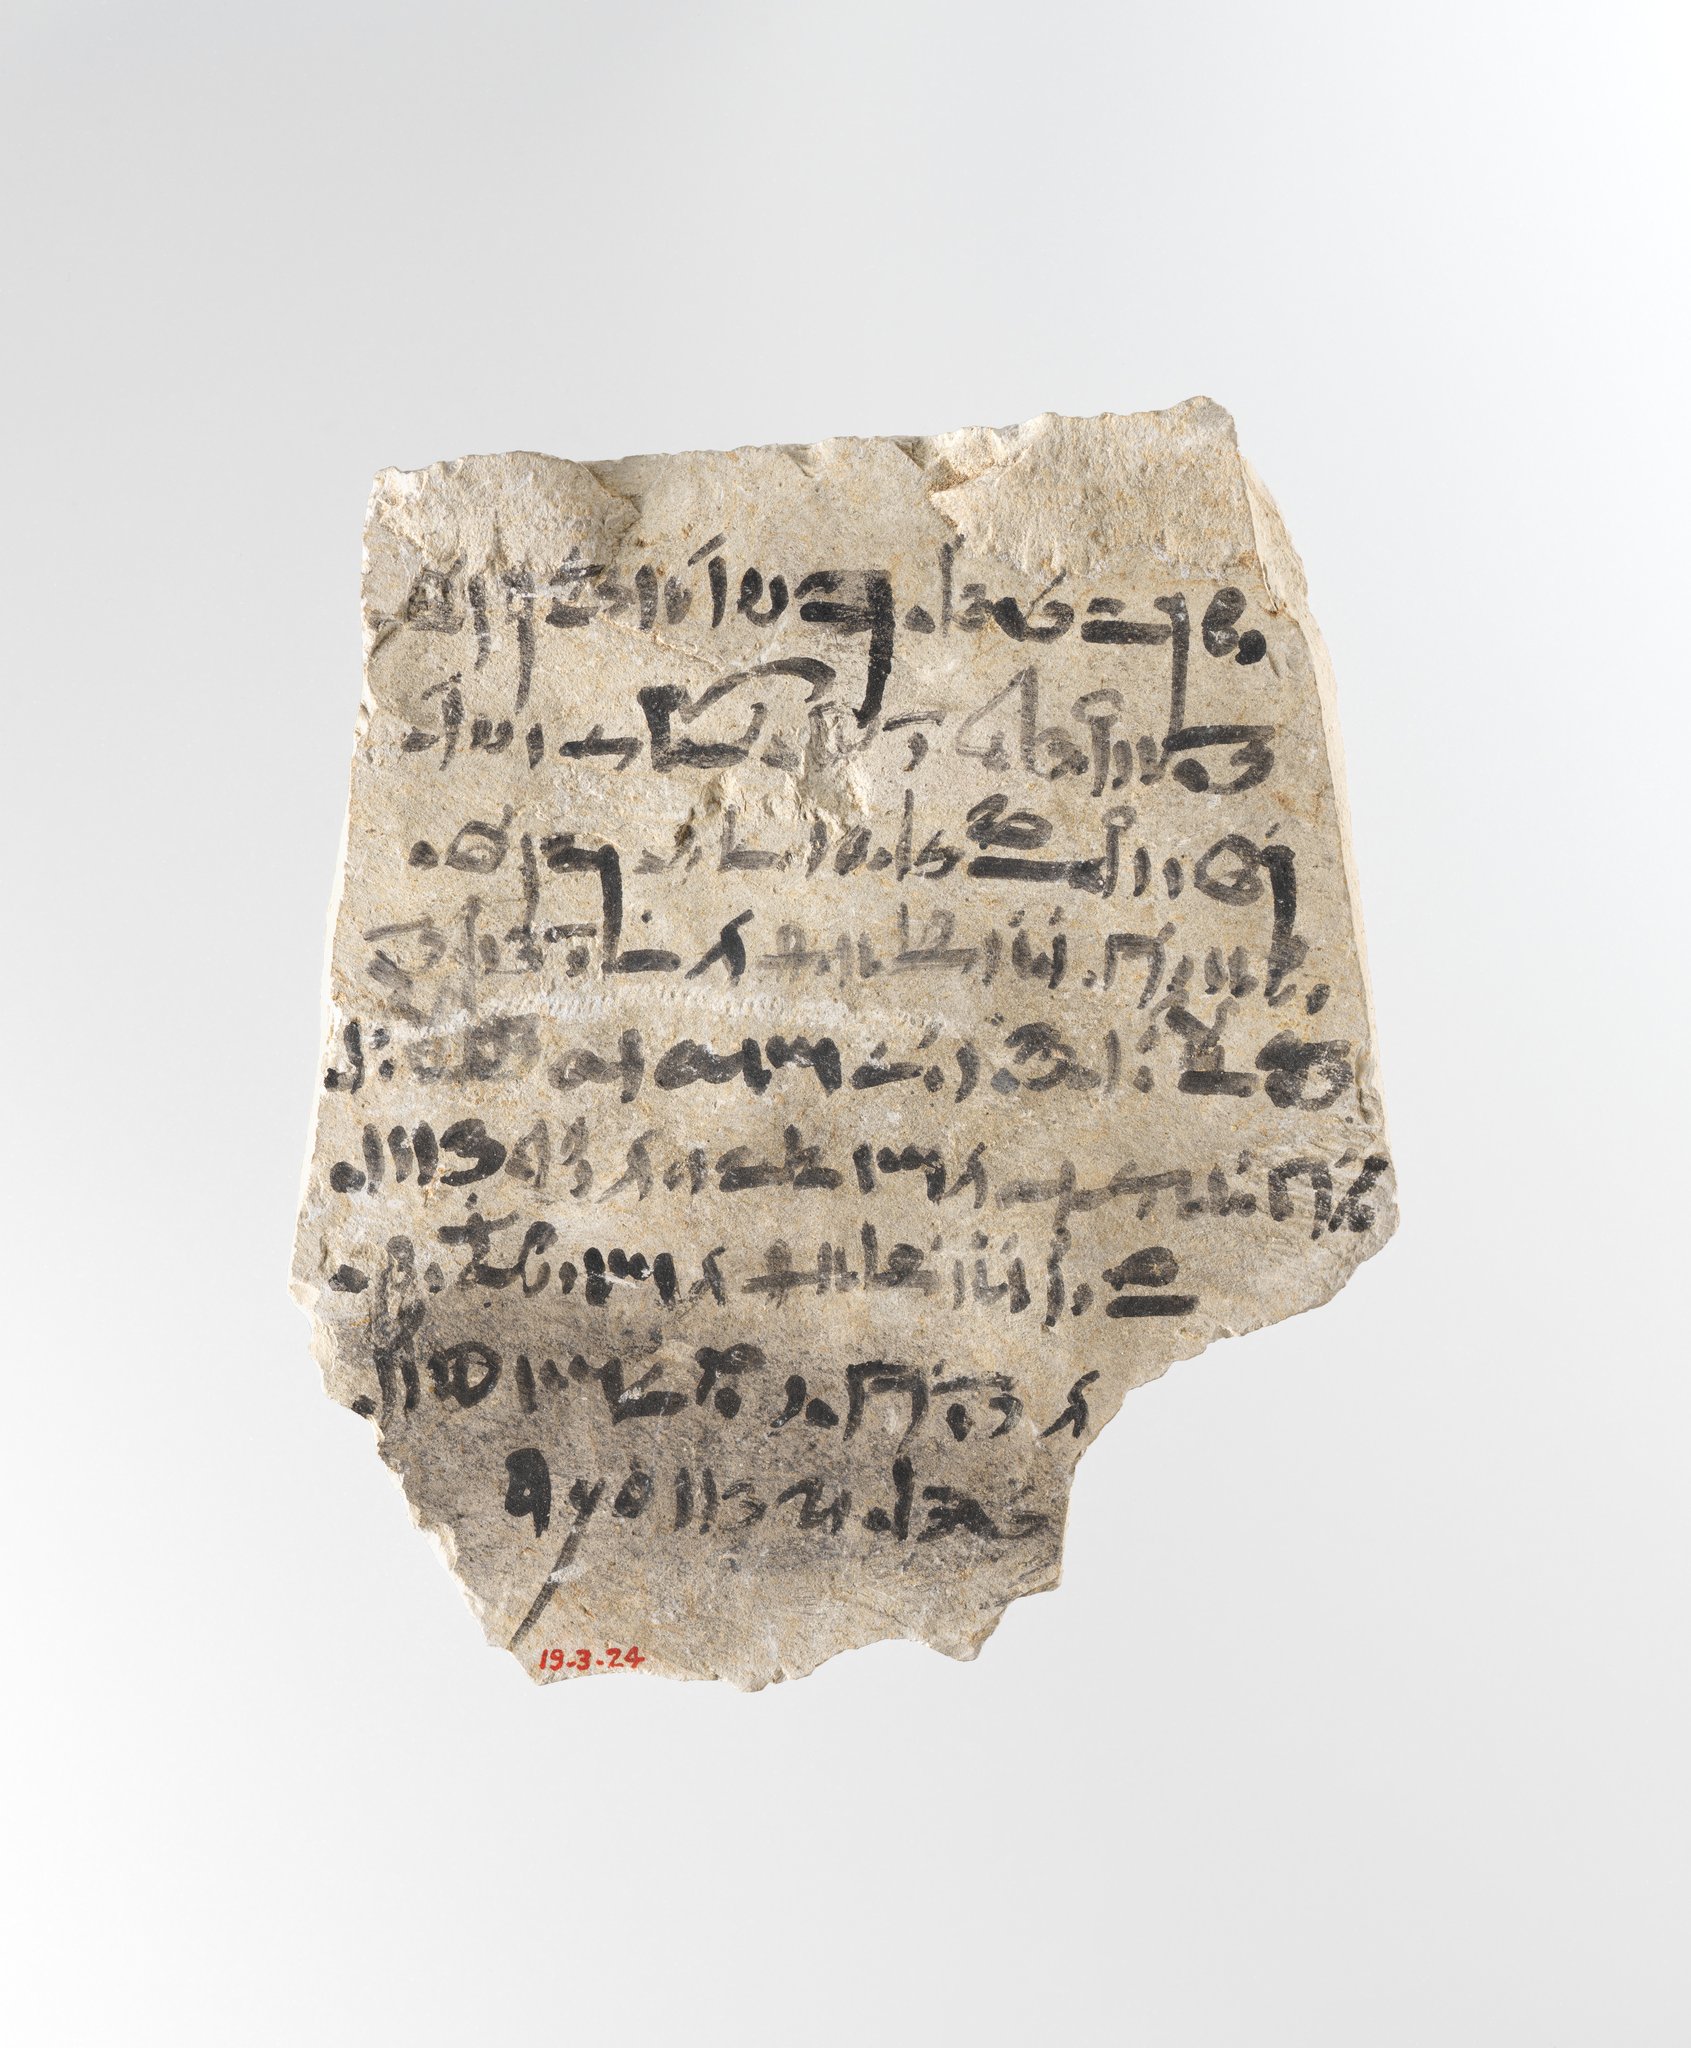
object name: ostracon, hieratic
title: Ostracon with hieratic inscription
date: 712-525 BCE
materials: ink, limestone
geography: egypt